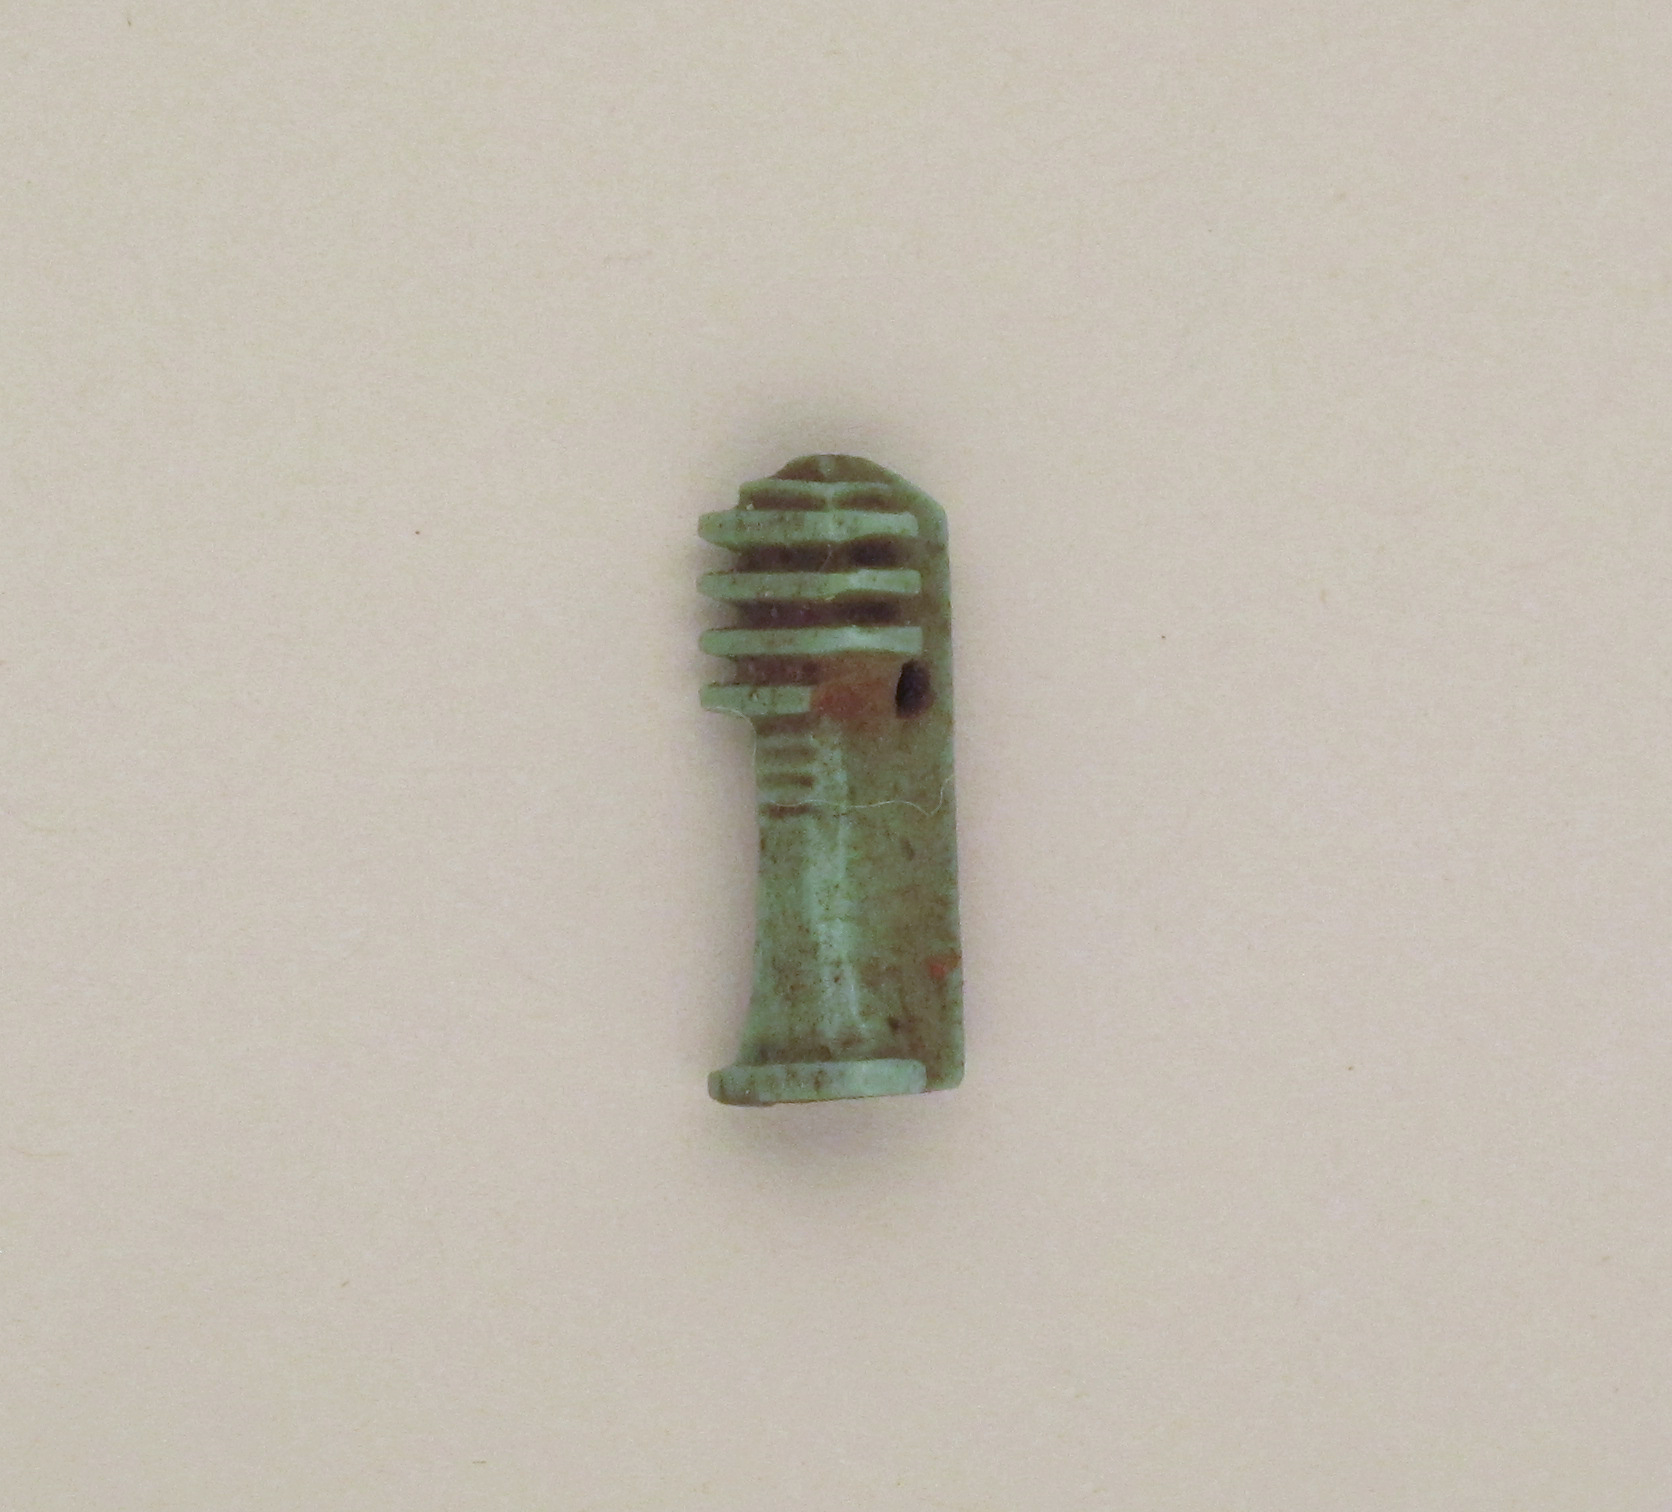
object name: amulet, djed pillar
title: Faience djed-pillar amulet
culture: egyptian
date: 664-630 BCE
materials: faience